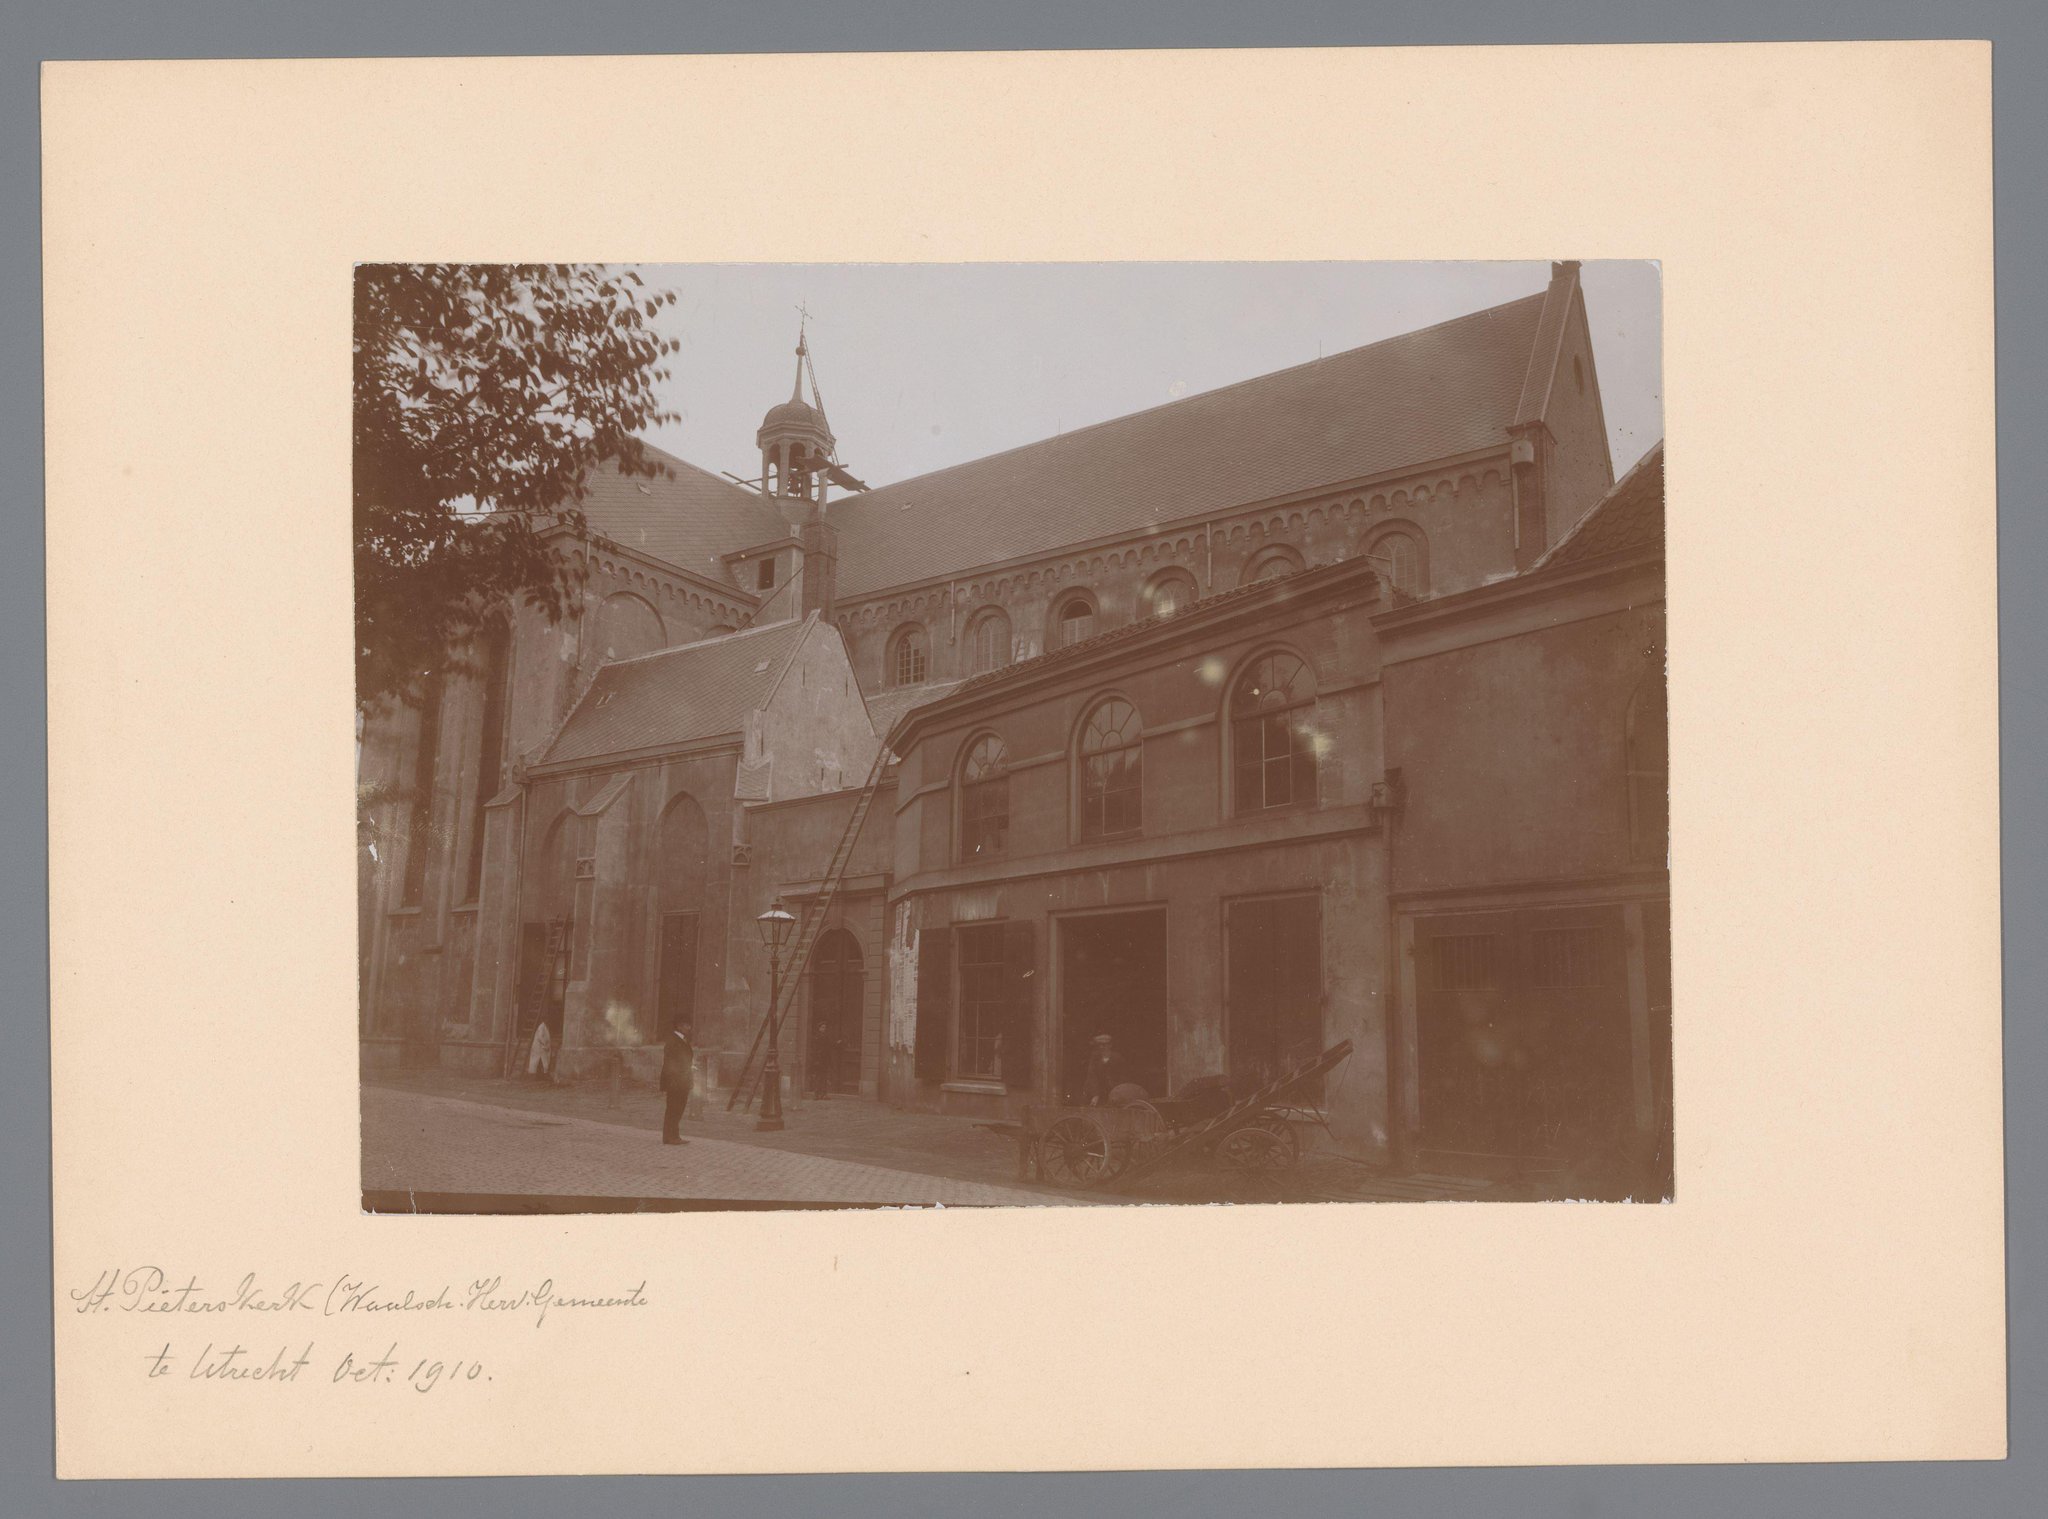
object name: photograph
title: Gezicht op de Sint-Pieterskerk te Utrecht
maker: anoniem (monumentenzorg)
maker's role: fotograaf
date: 1910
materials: cardboard, photographic support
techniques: collodion silver print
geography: utrecht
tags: church (exterior), street (+ city(-scape) with figures, staffage)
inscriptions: annotation: ‘St. Pieterskerk Waalsch Herv. gemeente/ te Utrecht oct: 1910’